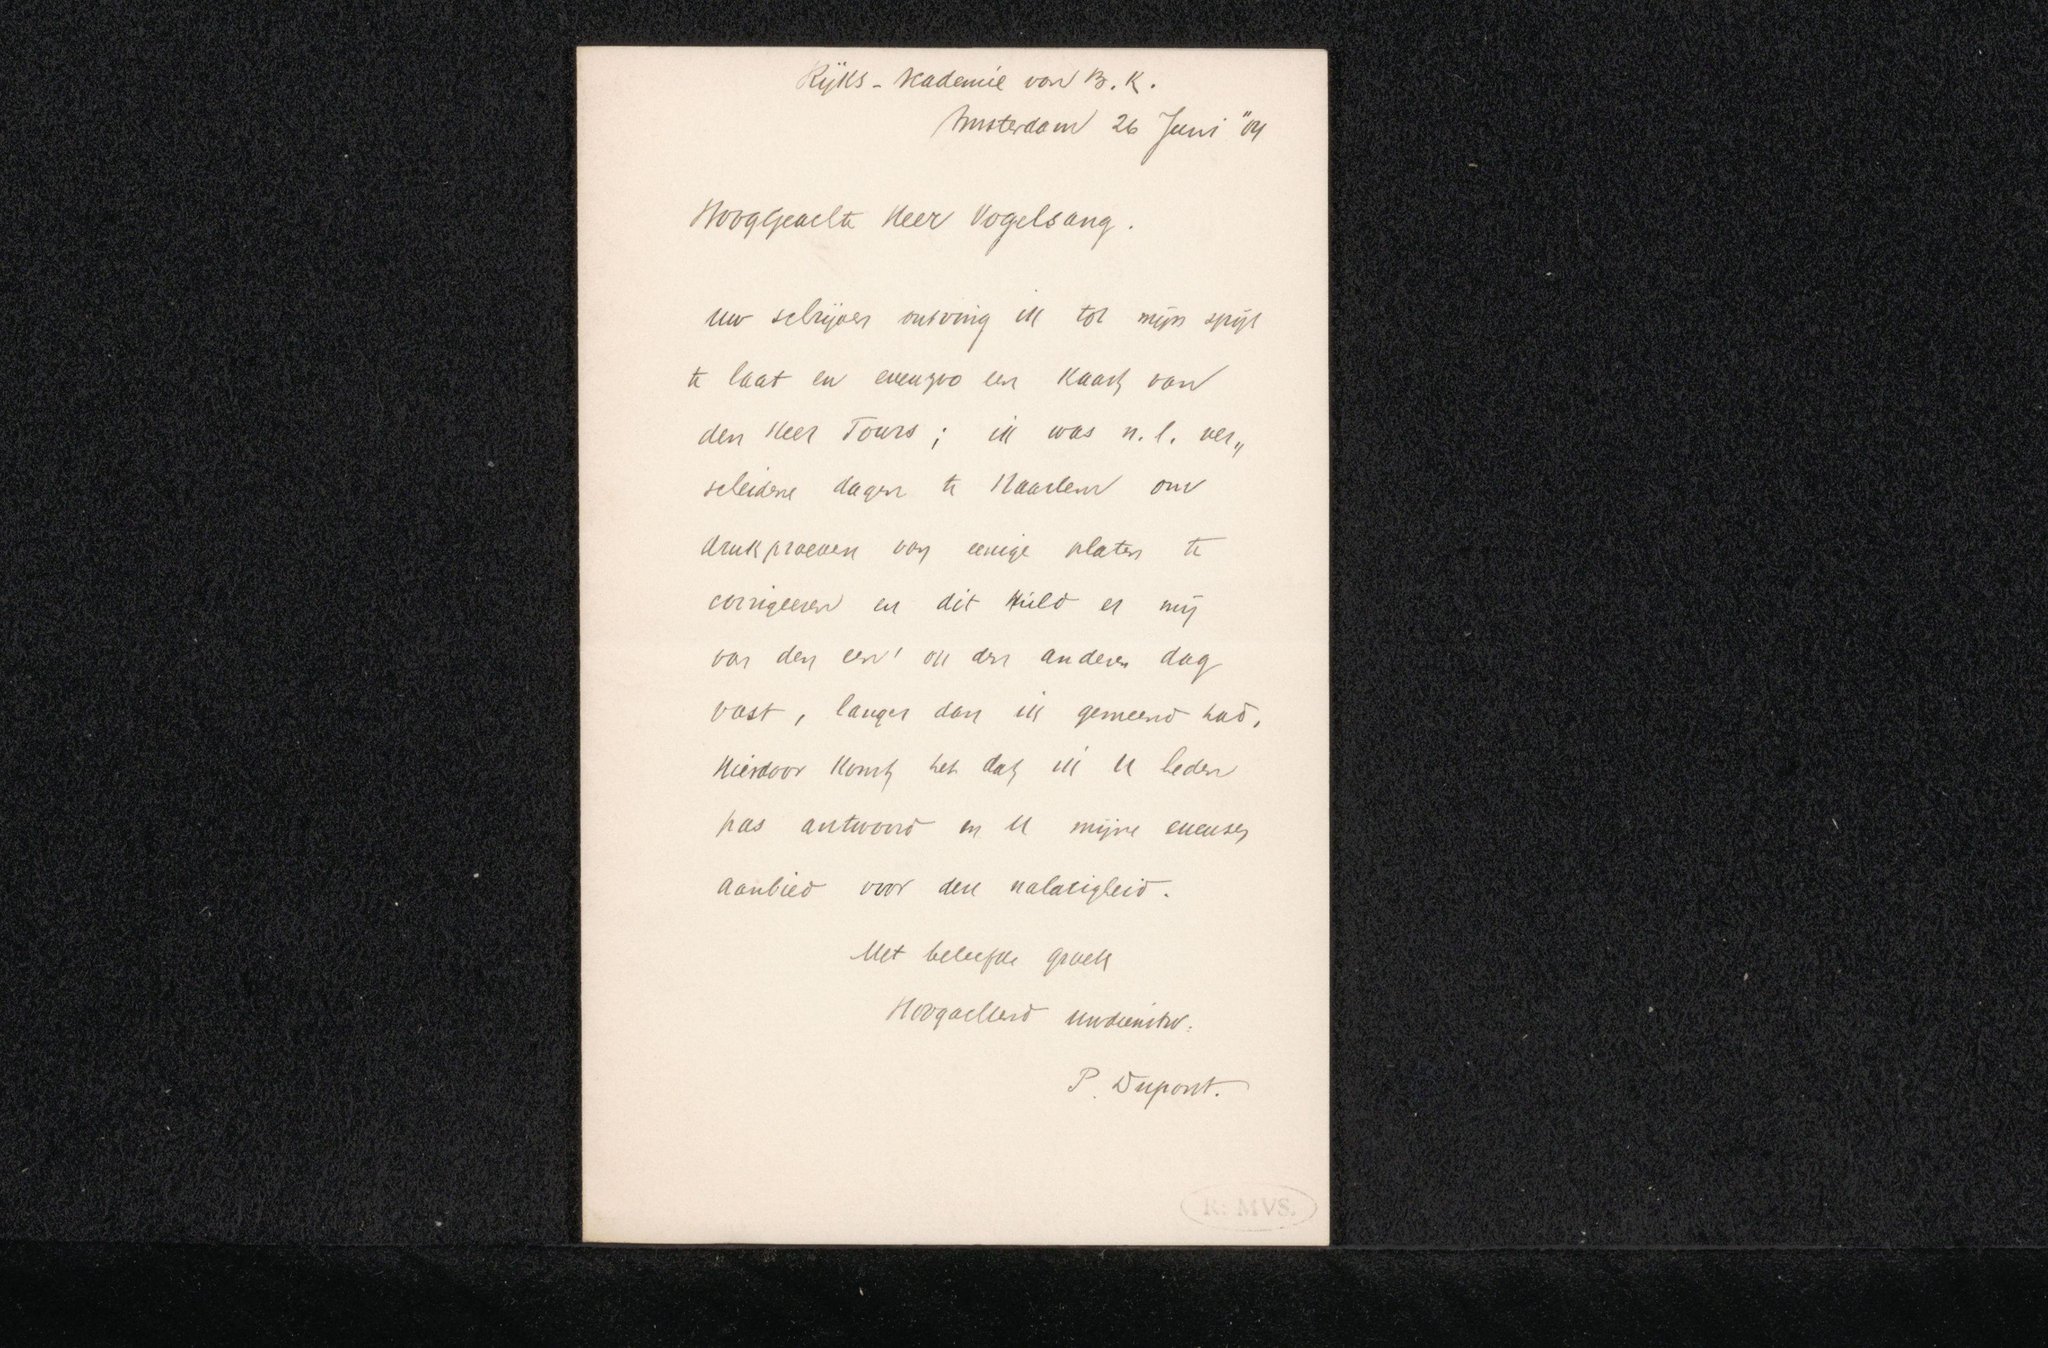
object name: letter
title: Brief aan Willem Vogelsang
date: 1904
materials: ink, paper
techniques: pen, writing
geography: amsterdam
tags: cigarette, caricatures (human types), the graphic arts, adult man, haarlem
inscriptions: watermark, collector's mark: Lugt 2228